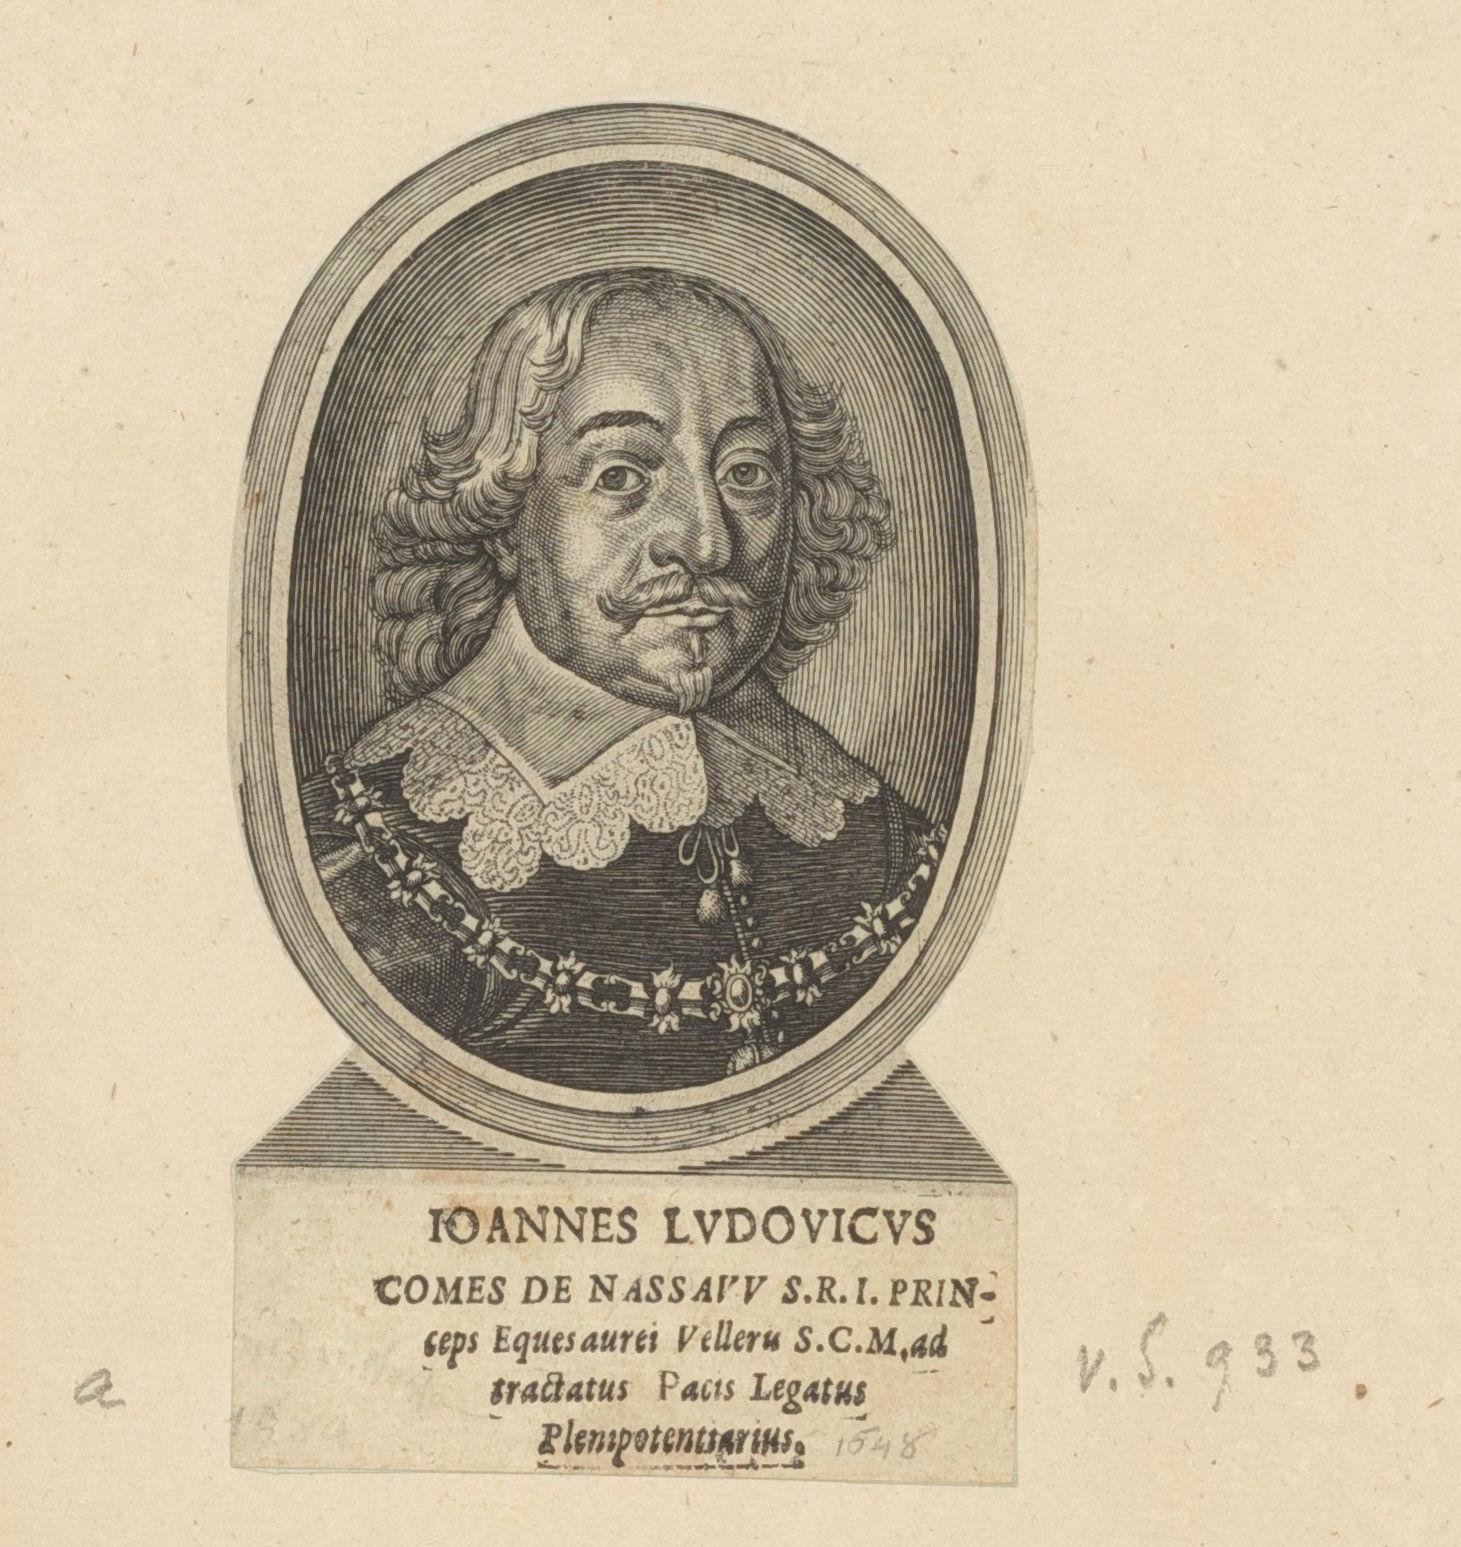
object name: print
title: Joannes Ludovicus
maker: Anonymous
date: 1652-1657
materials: paper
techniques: engraving, letterpress printing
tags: historical persons, knighthood order of the golden fleece - insignia of a knighthood order, e.g.: badge, chain (with name of order)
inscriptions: stamp, collector's mark: Lugt 1641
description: Prent met een andere letterzetting gebruikt in: Brachelius, Adolphus. Historia Adolphi Brachelii Sui Temporis Rerum Bello Et Pace (...). Keulen: Johann Anton Kinckius, 1652. En in: Brachelius, Adolphus. Historiarum Nostri Temporis Authore Adolpho Brachelio. Keulen: Johann Anton Kinckius, 1657.